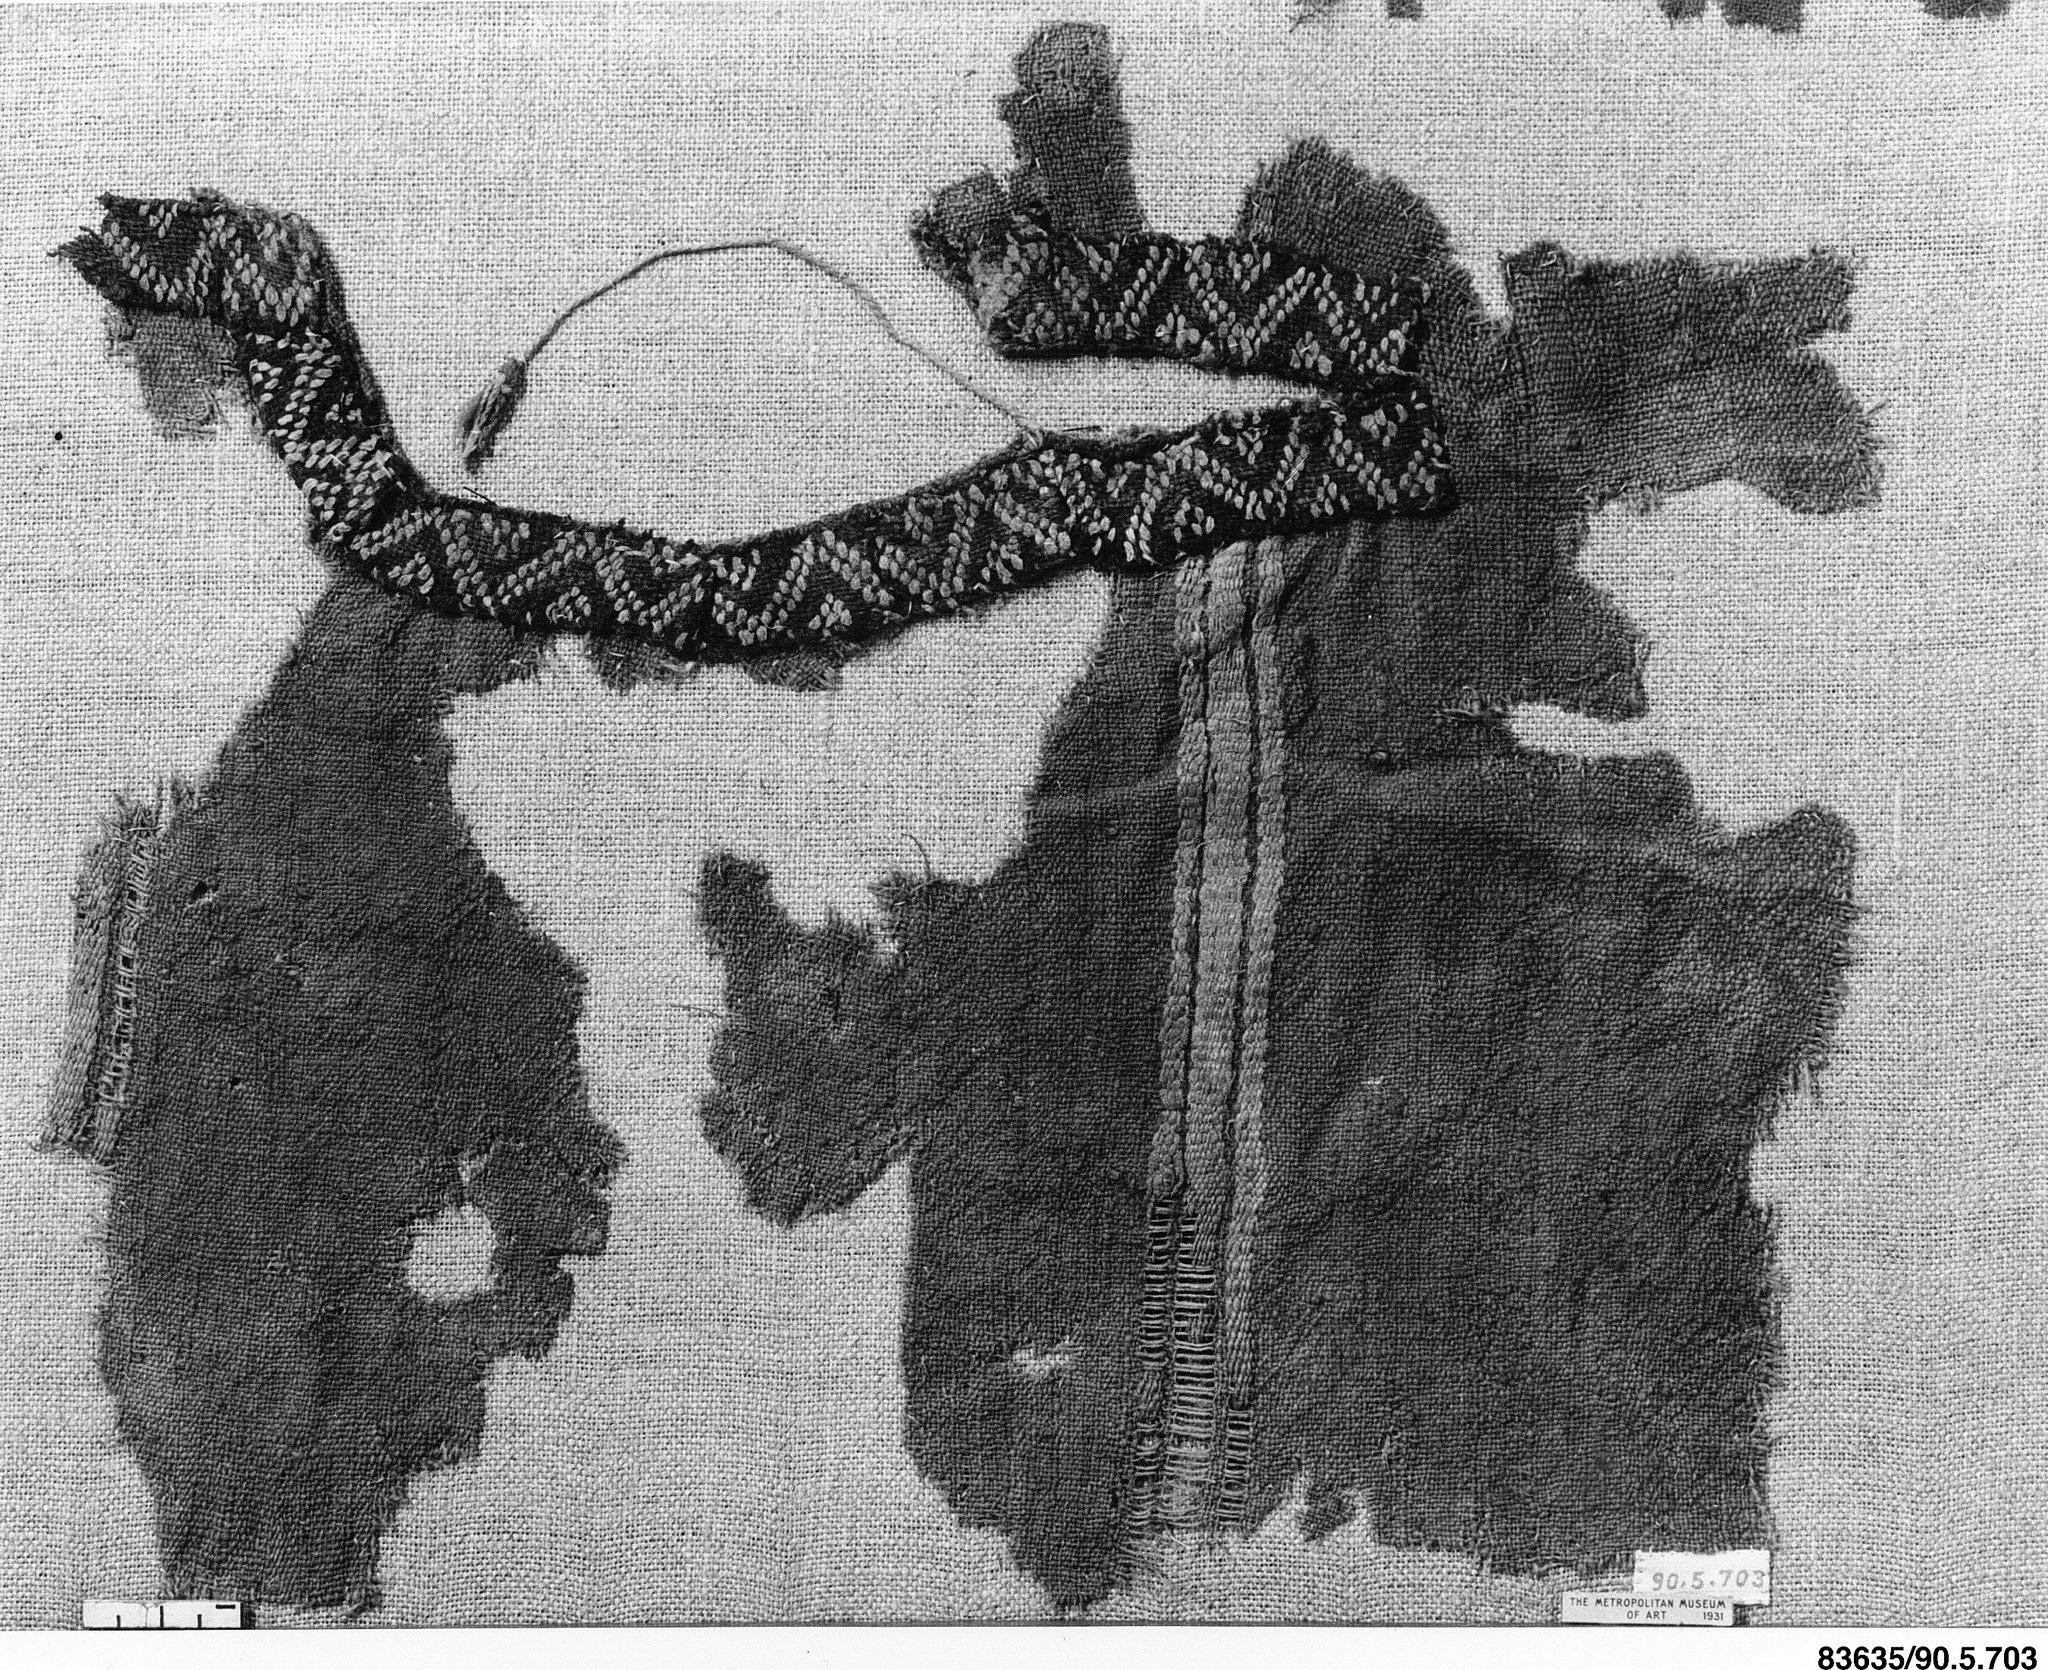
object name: tunic fragment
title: Fragment of a Tunic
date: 401-600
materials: linen, wool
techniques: weave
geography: egypt